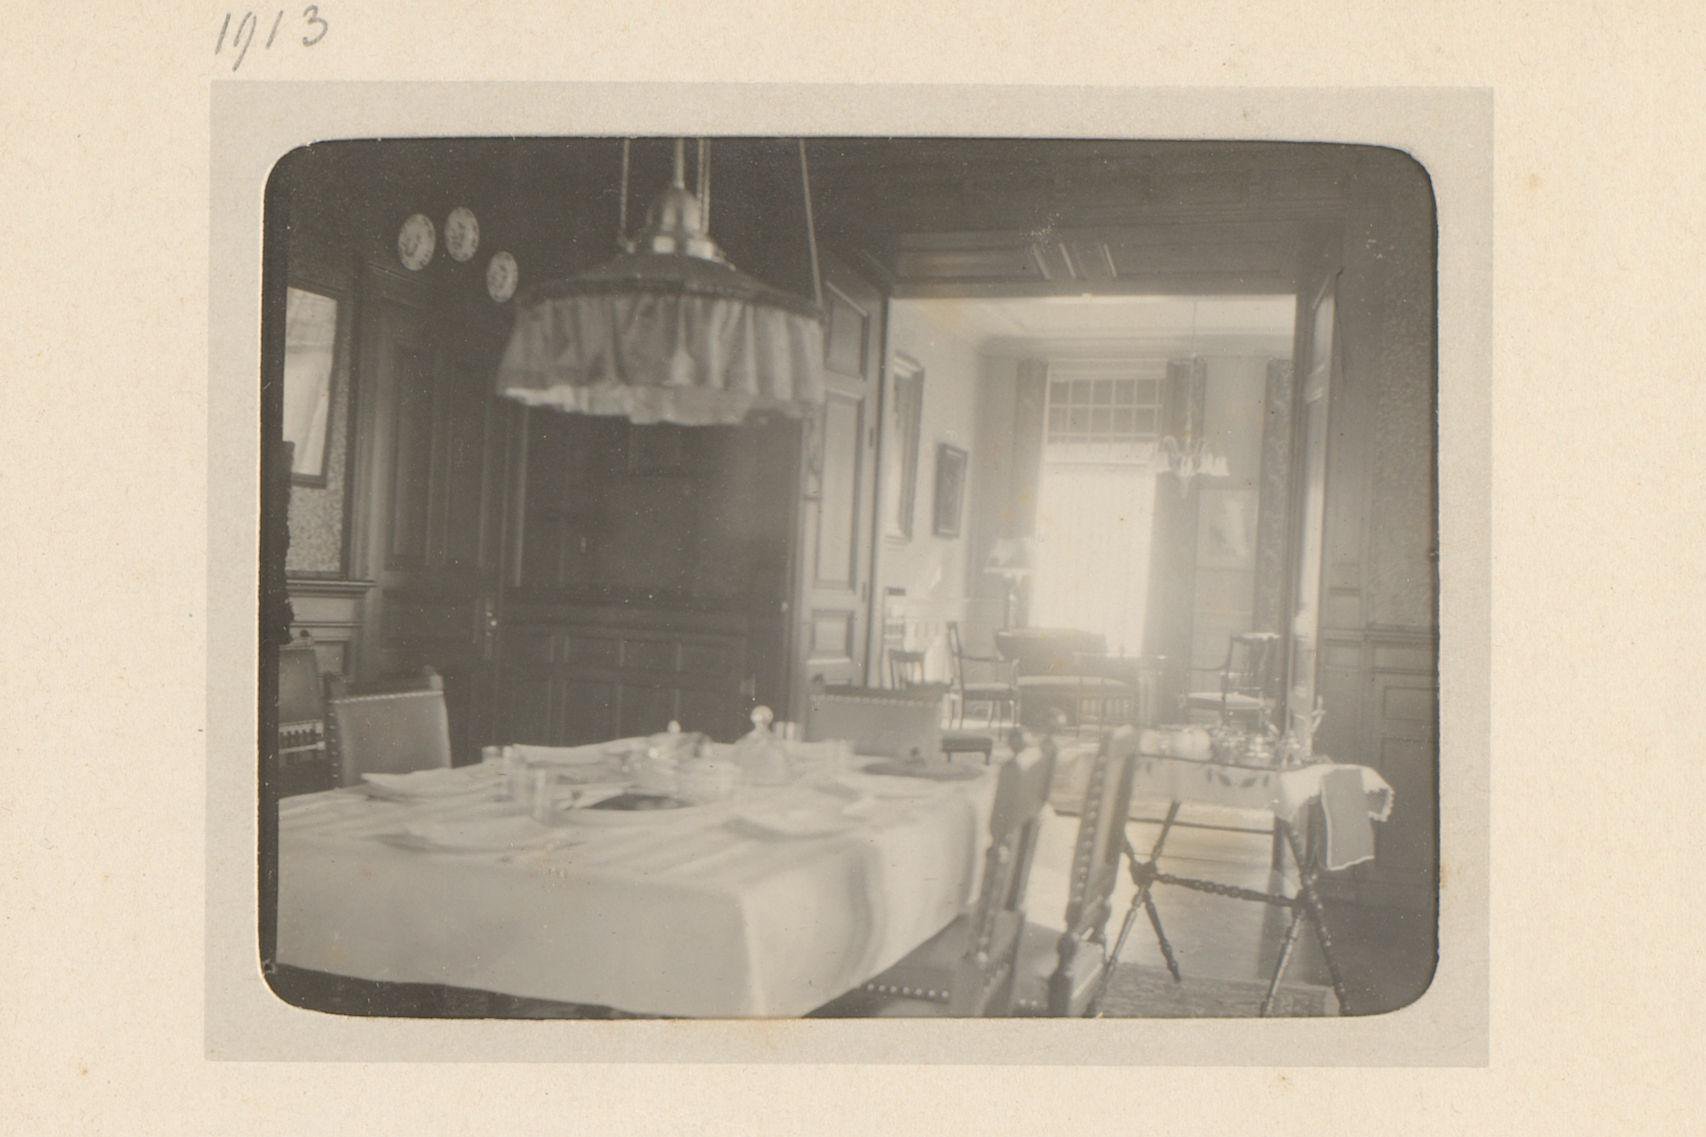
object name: photograph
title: Interieur van de Van Eeghenstraat 88 te Amsterdam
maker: liesbeth overhoff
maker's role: fotograaf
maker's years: 1895-1969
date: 1913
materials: paper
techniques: gelatin silver print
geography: amsterdam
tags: open hearth, fire-place, interior ~ representation of a building, dining-room, amsterdam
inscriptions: inscription: ‘1913’